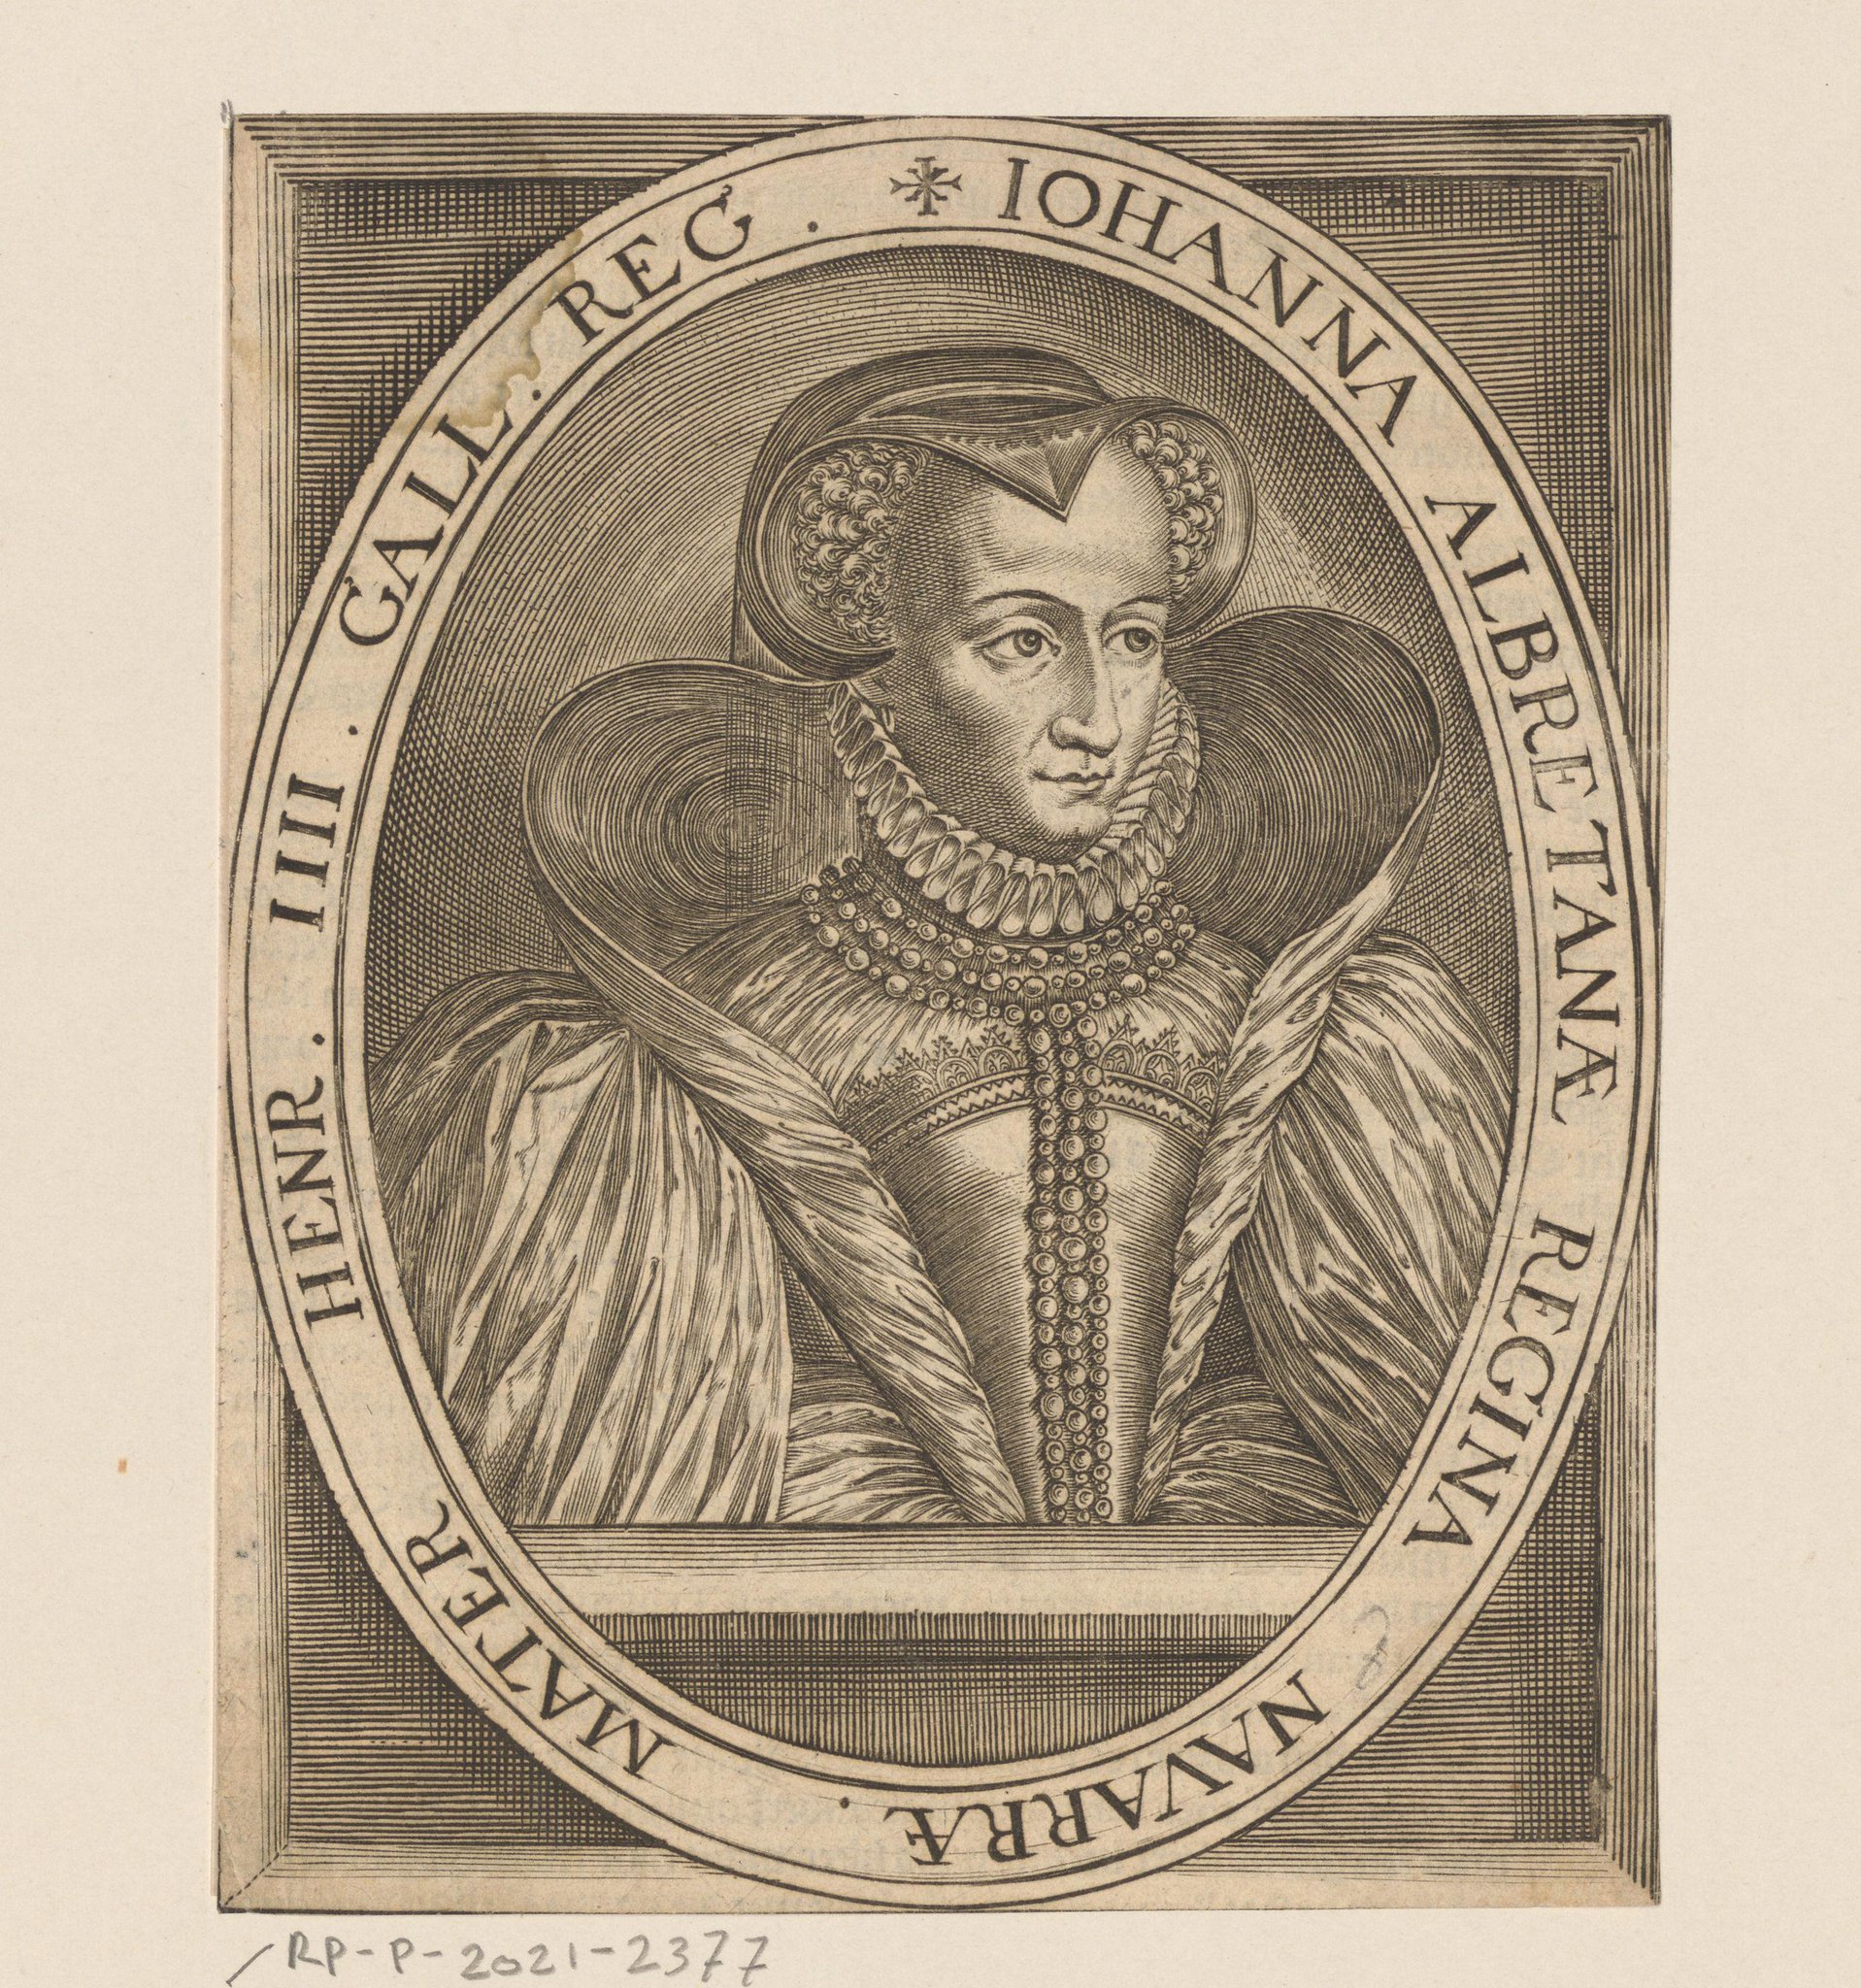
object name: print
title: Portret van Johanna van Albret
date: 1615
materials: paper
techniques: engraving, letterpress printing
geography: delft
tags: historical persons - bb - woman, queen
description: Prent uit: Clerck, Nicolaes de. Tooneel der keyseren en coningen van Christenryck sedert den onderganck van het Griecks keyserdom. Delft: Nicolaes de Clerck, 1615.